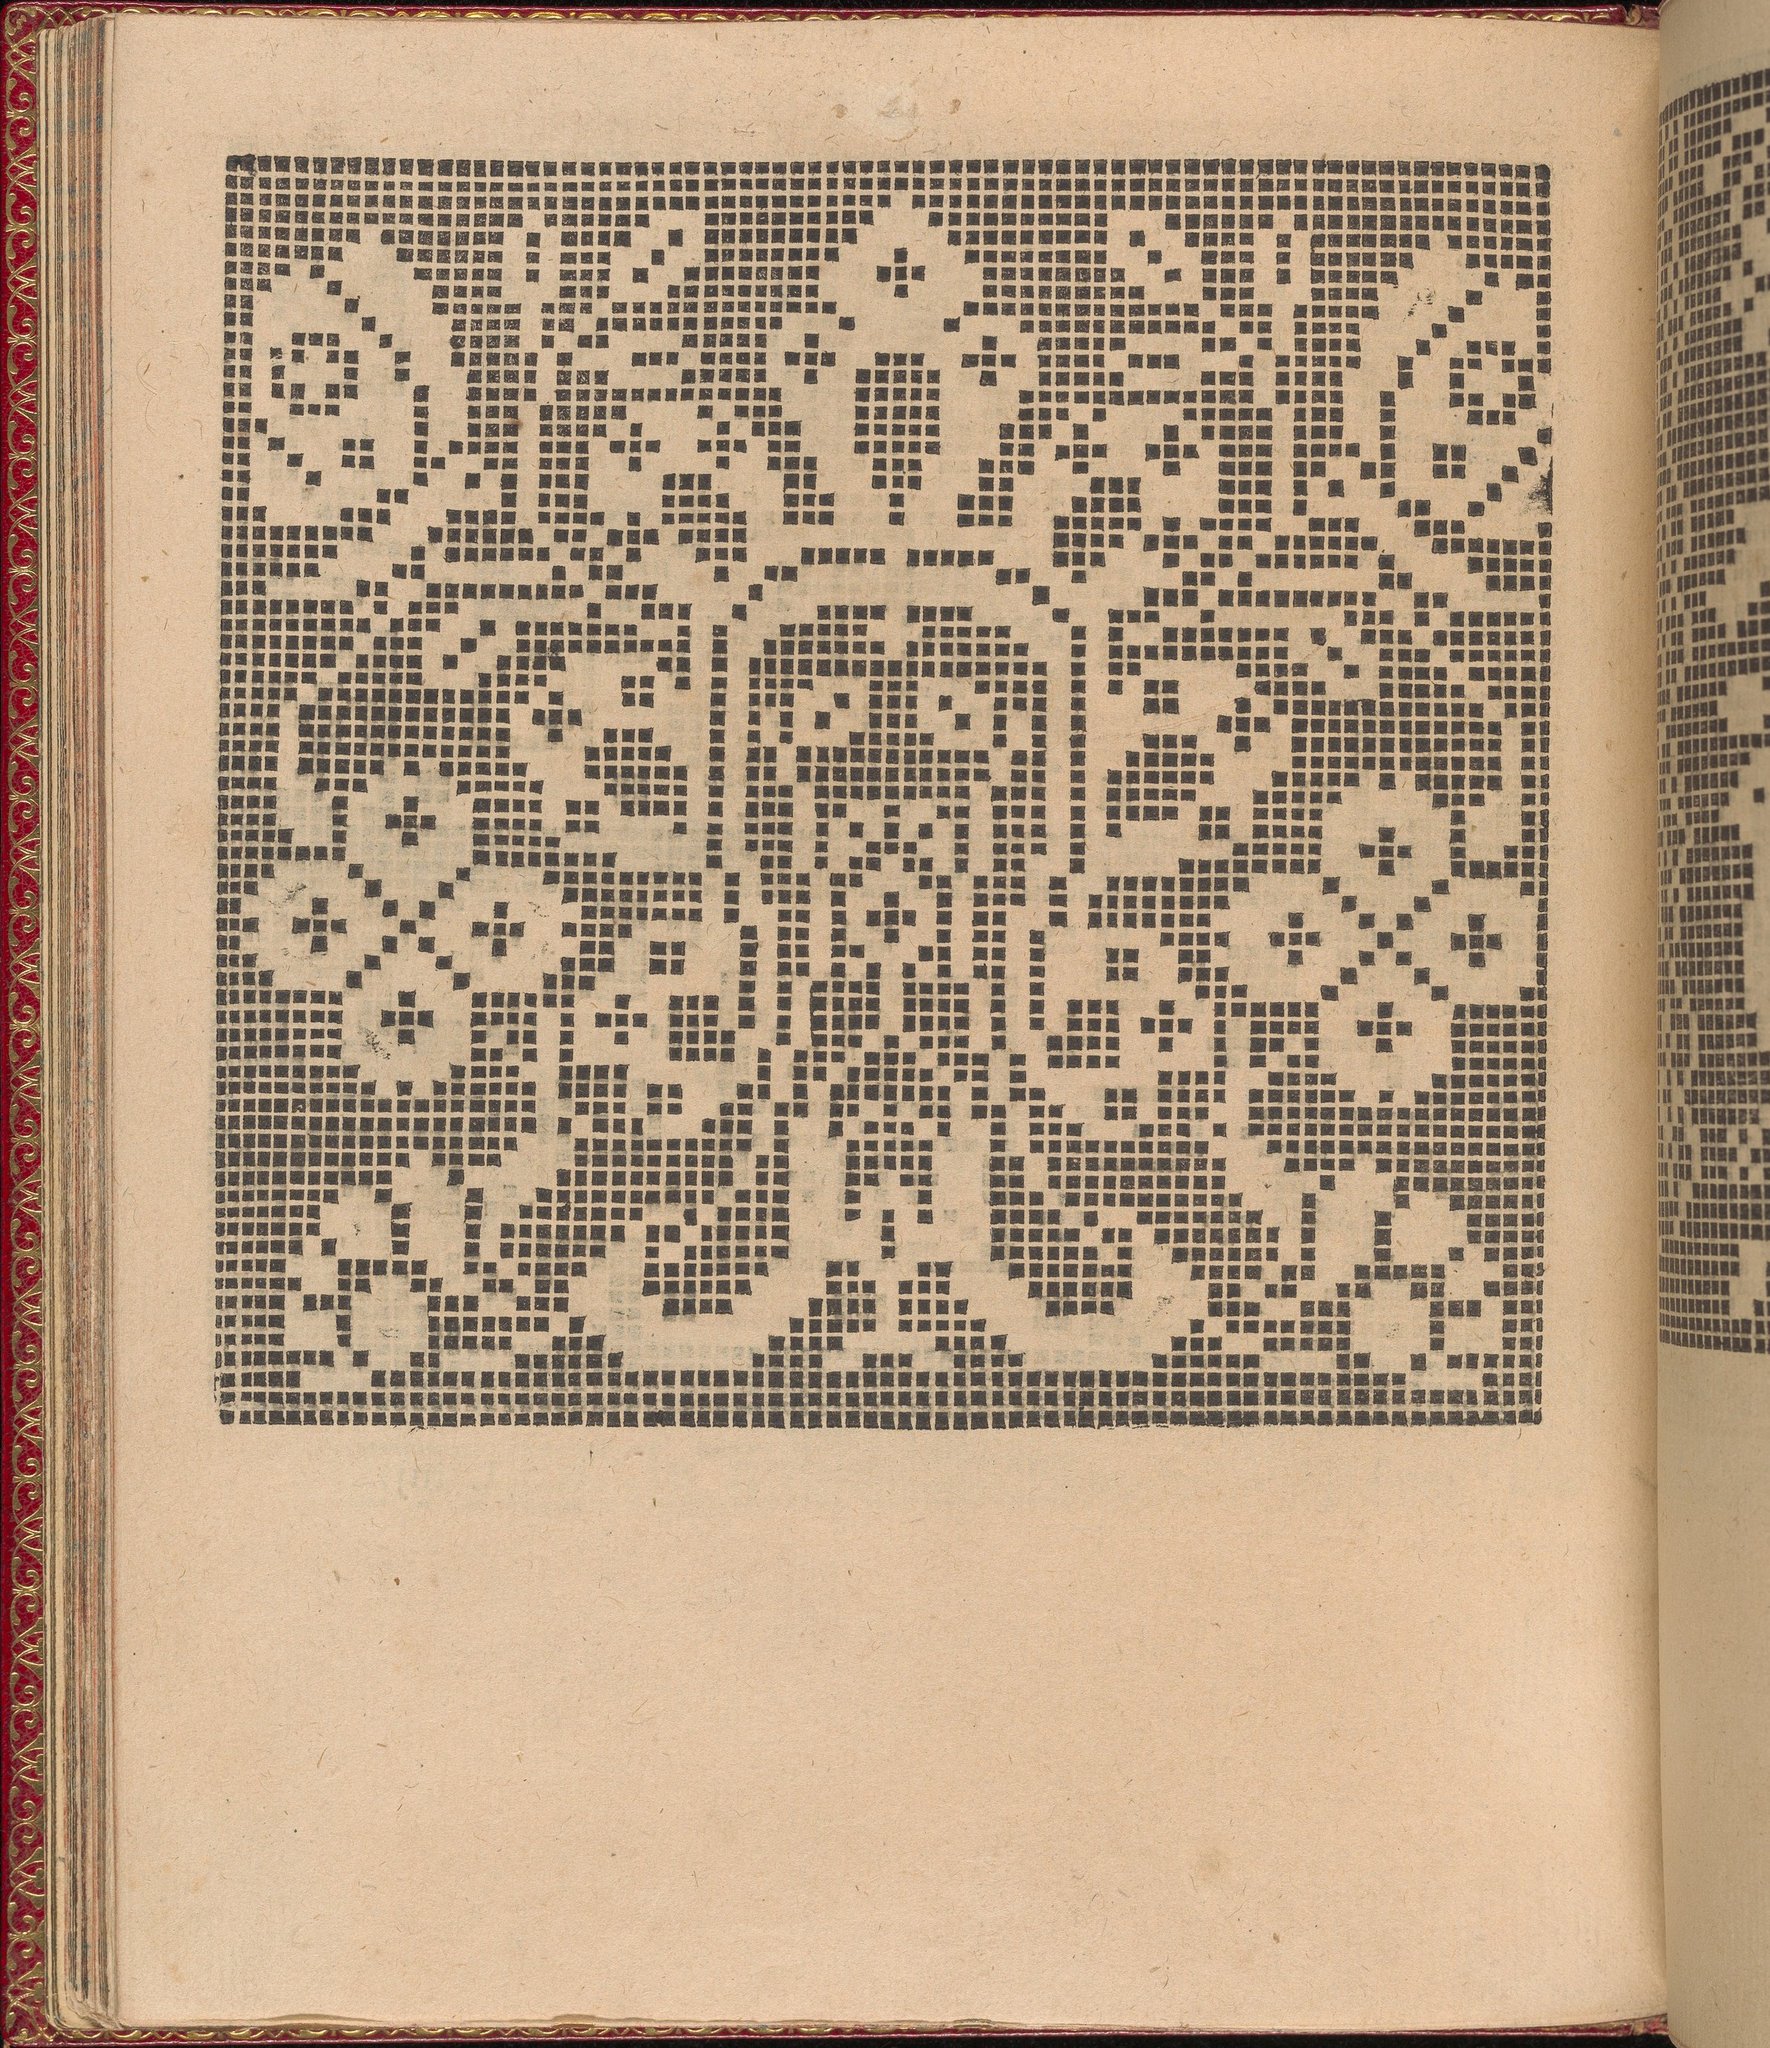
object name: book print ornament architecture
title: Les Singuliers et Nouveaux Portraicts... page 43 (verso)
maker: federico de vinciolo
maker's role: designer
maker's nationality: italian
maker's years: 1582-1599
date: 1588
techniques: woodcut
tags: butterflies,snails,flowers